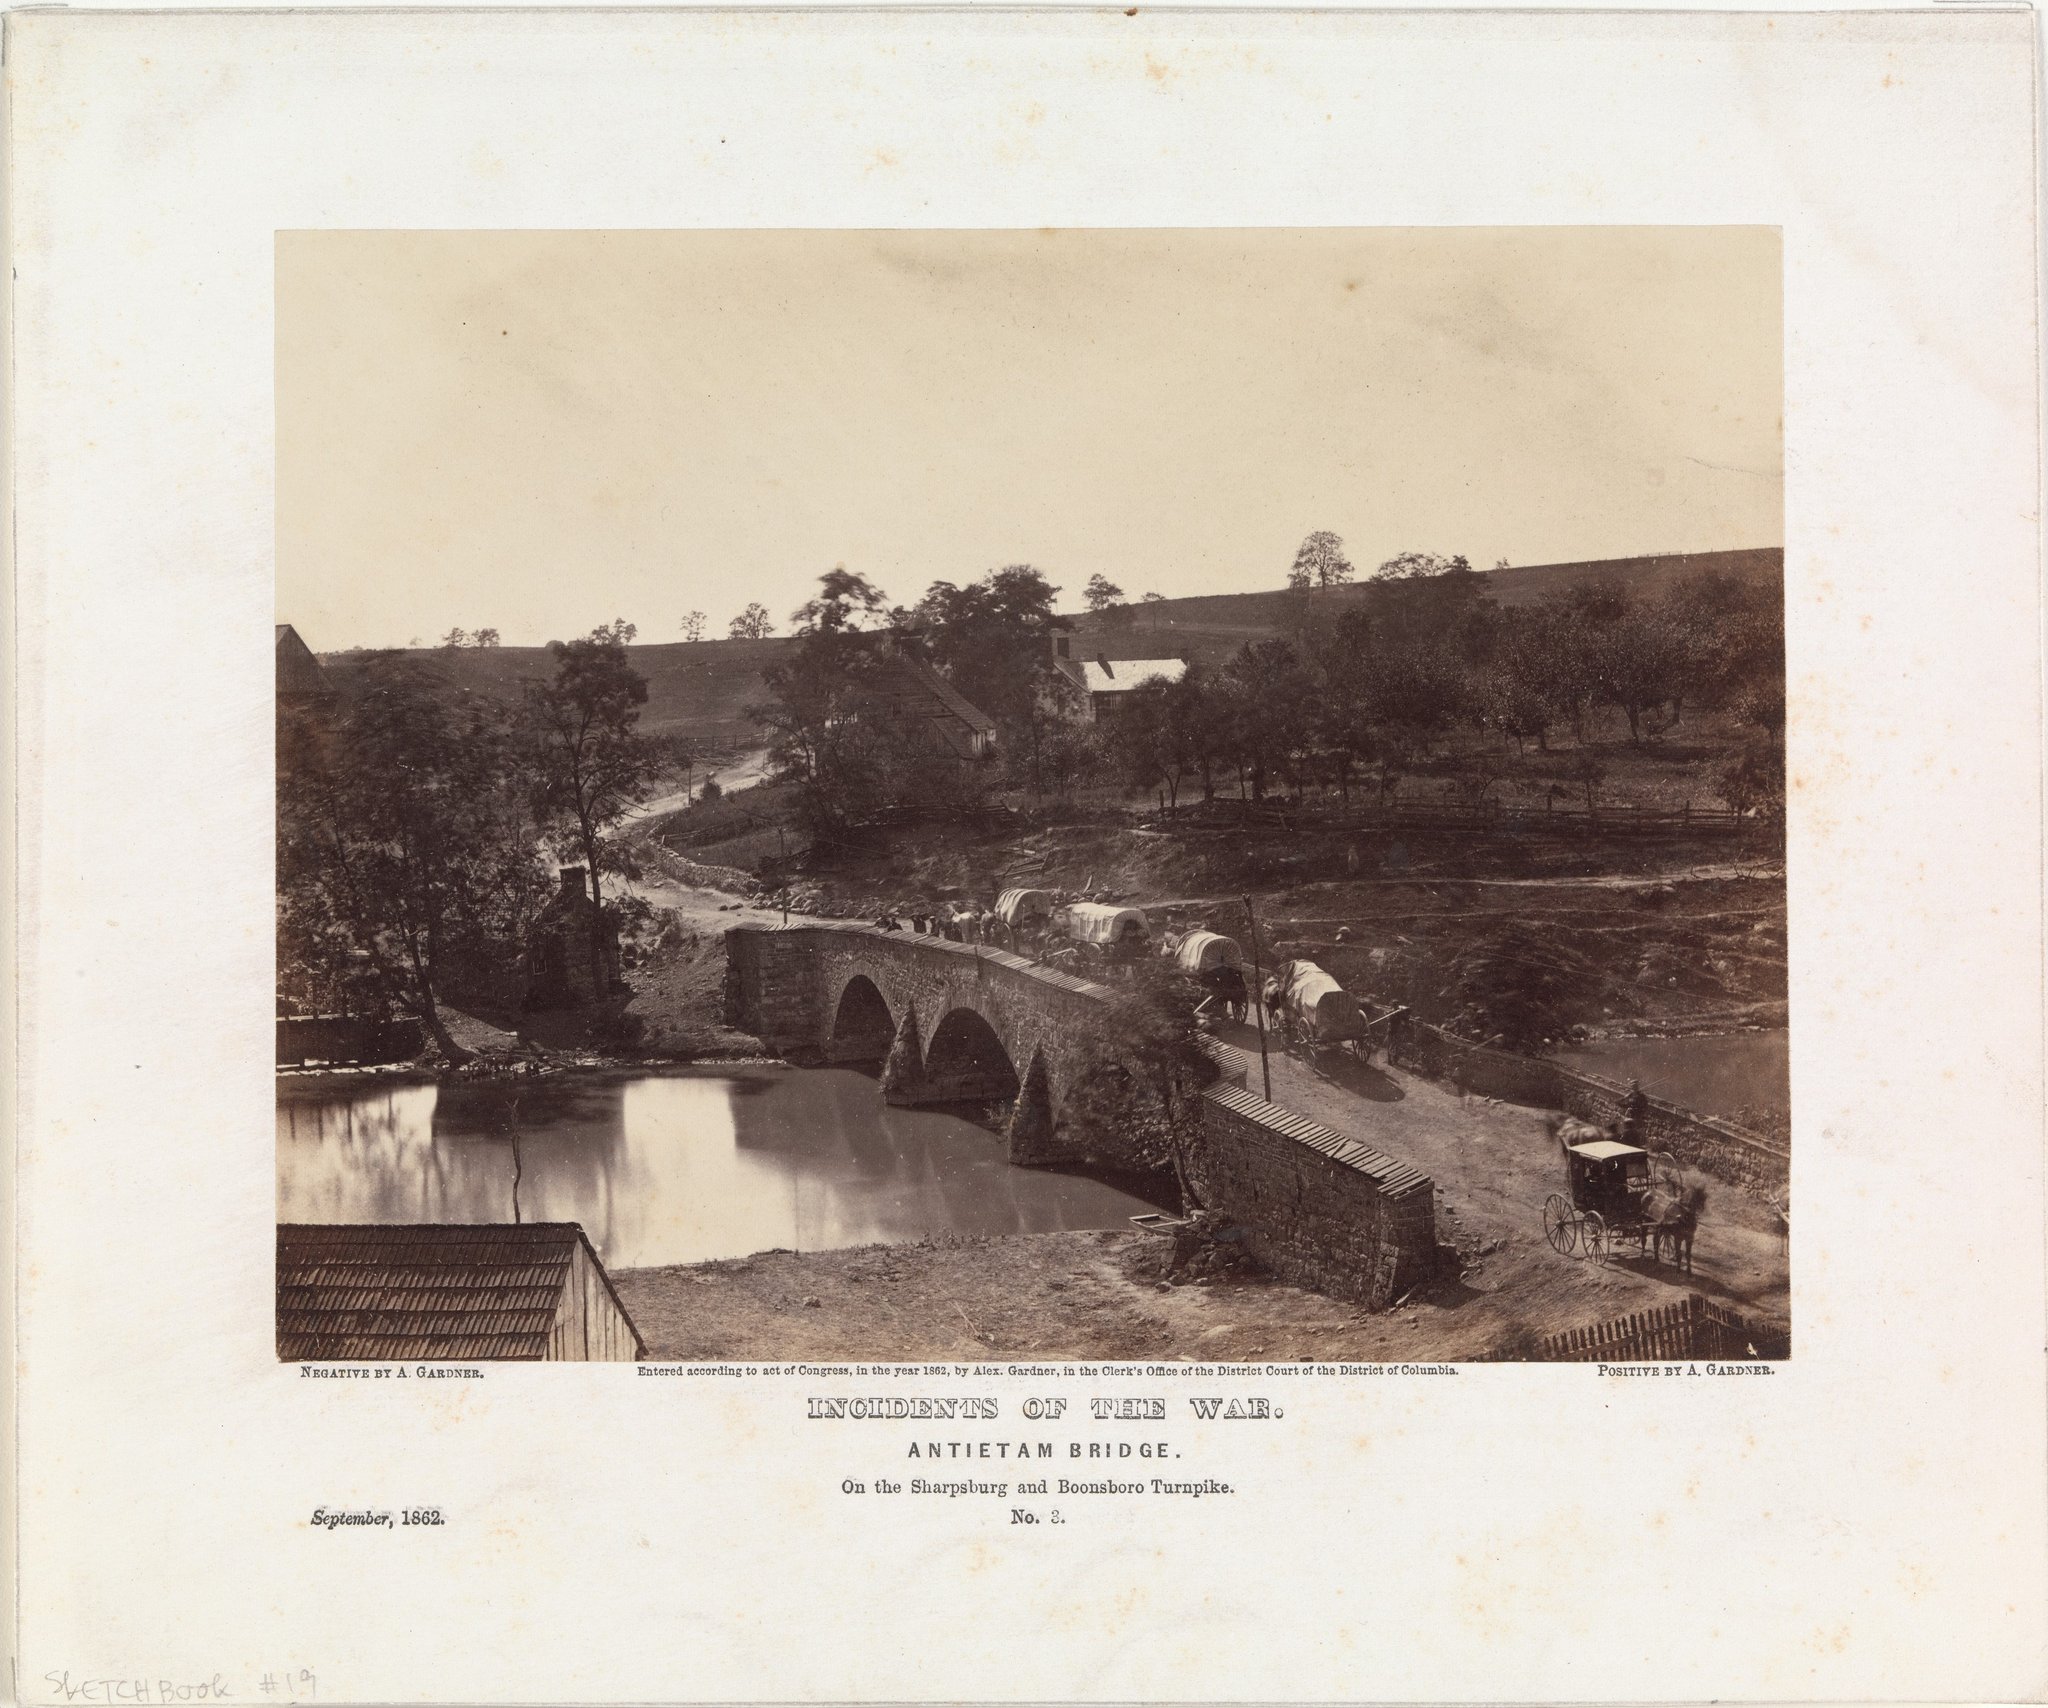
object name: photograph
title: Antietam Bridge, On the Sharpsburgh and Boonsboro Turnpike, No. 3, September 1862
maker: alexander gardner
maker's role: artist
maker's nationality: american, scottish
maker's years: 1821-1882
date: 1862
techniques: albumen silver print, glass negative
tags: bridges,american civil war,wagons